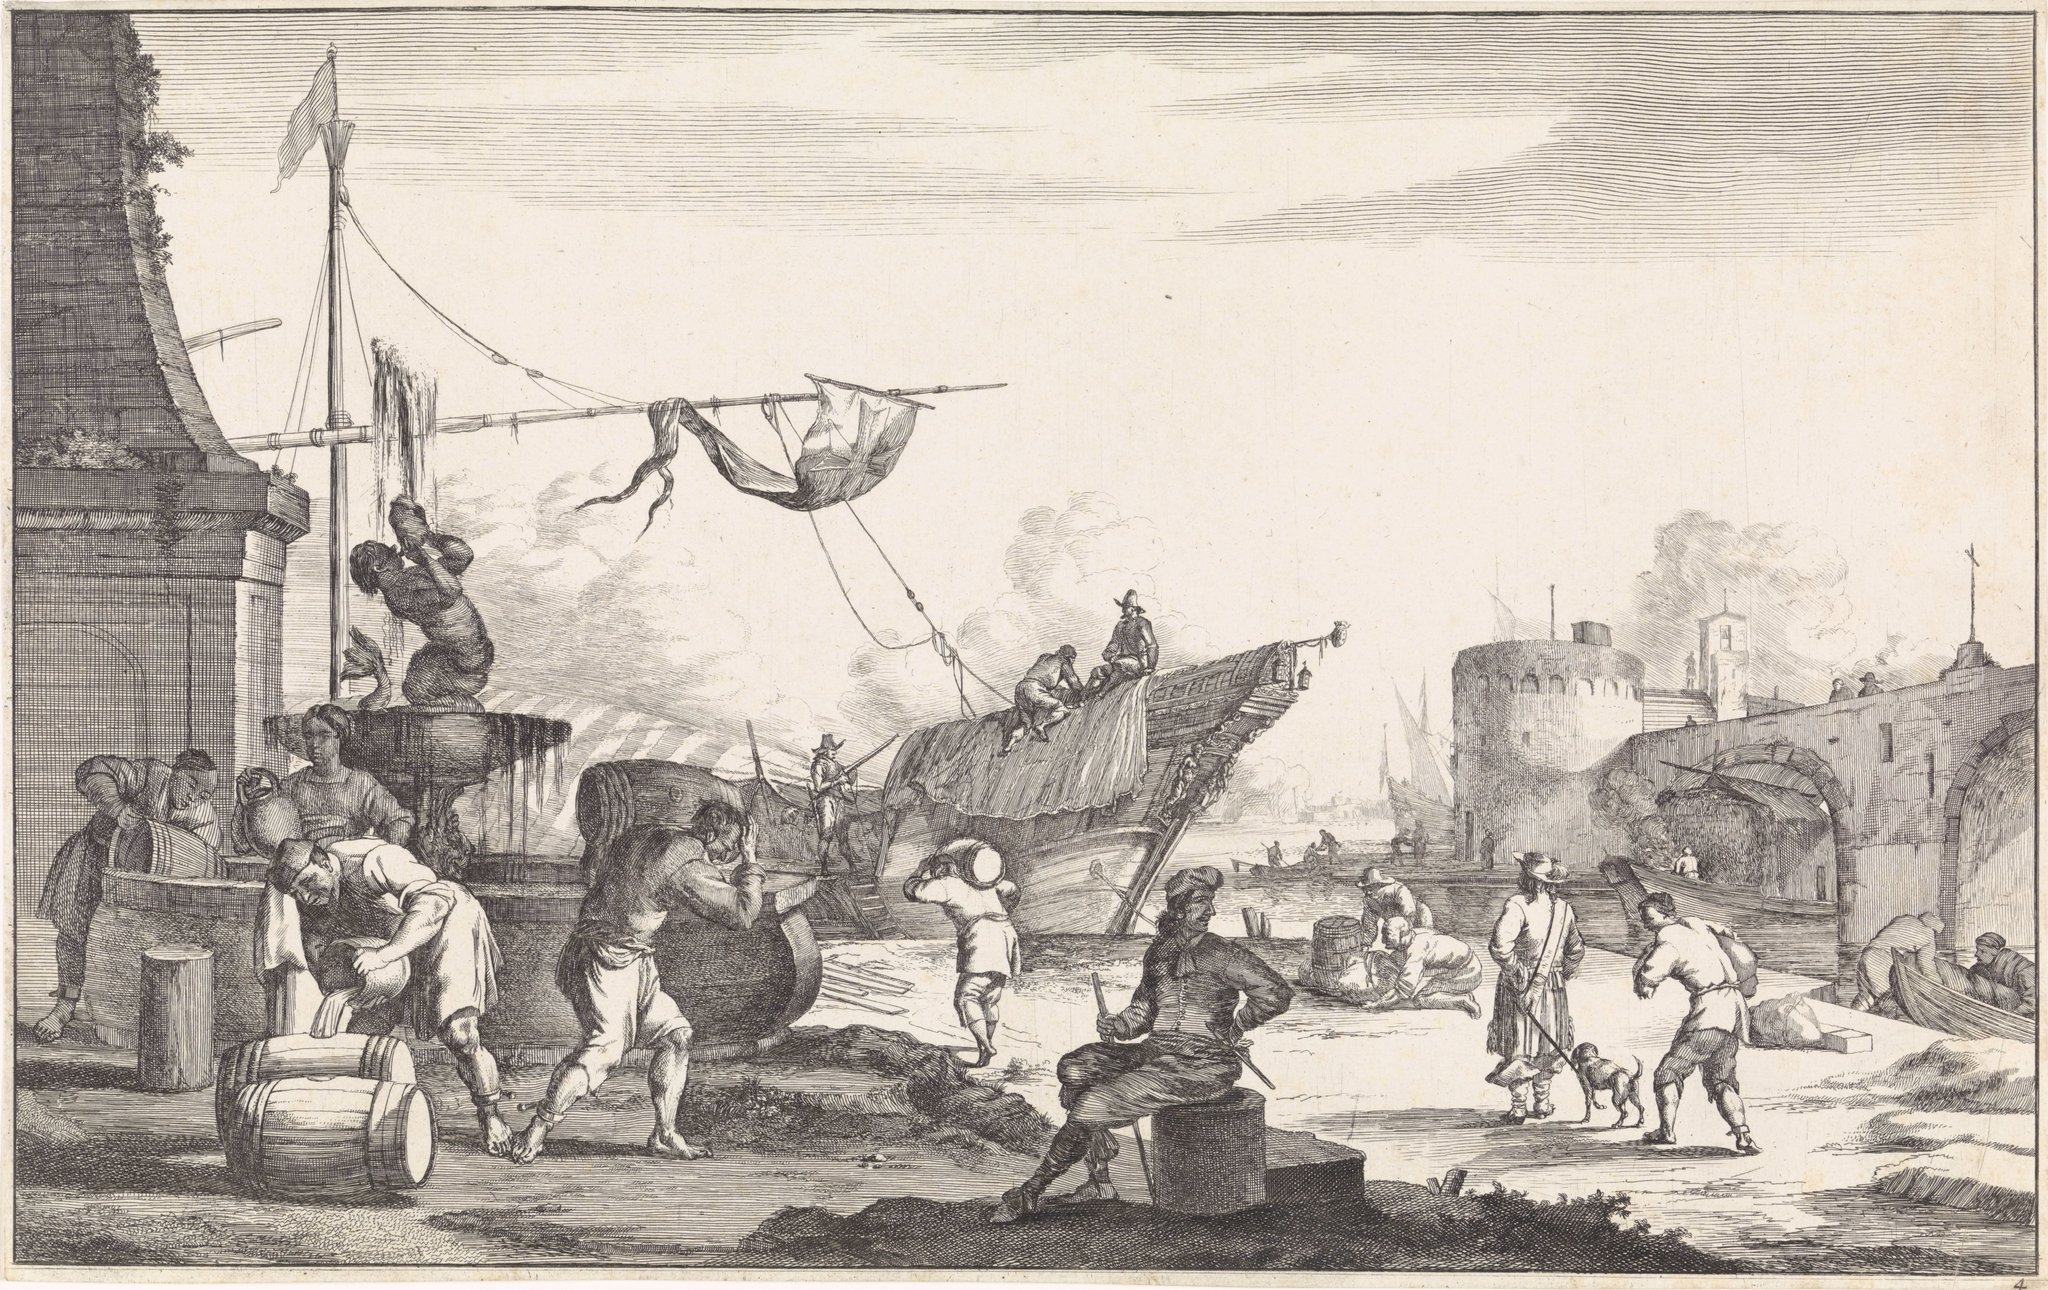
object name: print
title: Haven met verschillende mensen rond een fontein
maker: anthony van zijlvelt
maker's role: print maker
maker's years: 1637-1715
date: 1650-1695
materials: paper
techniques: etching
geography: amsterdam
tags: harbour, ornamental fountain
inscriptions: collector's mark: Lugt 10, collector's mark: Lugt 11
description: Havengezicht met links een fontein met het beeld van een triton, waar mensen tonnen en kruiken met water vullen. Op de achtergrond een schip.